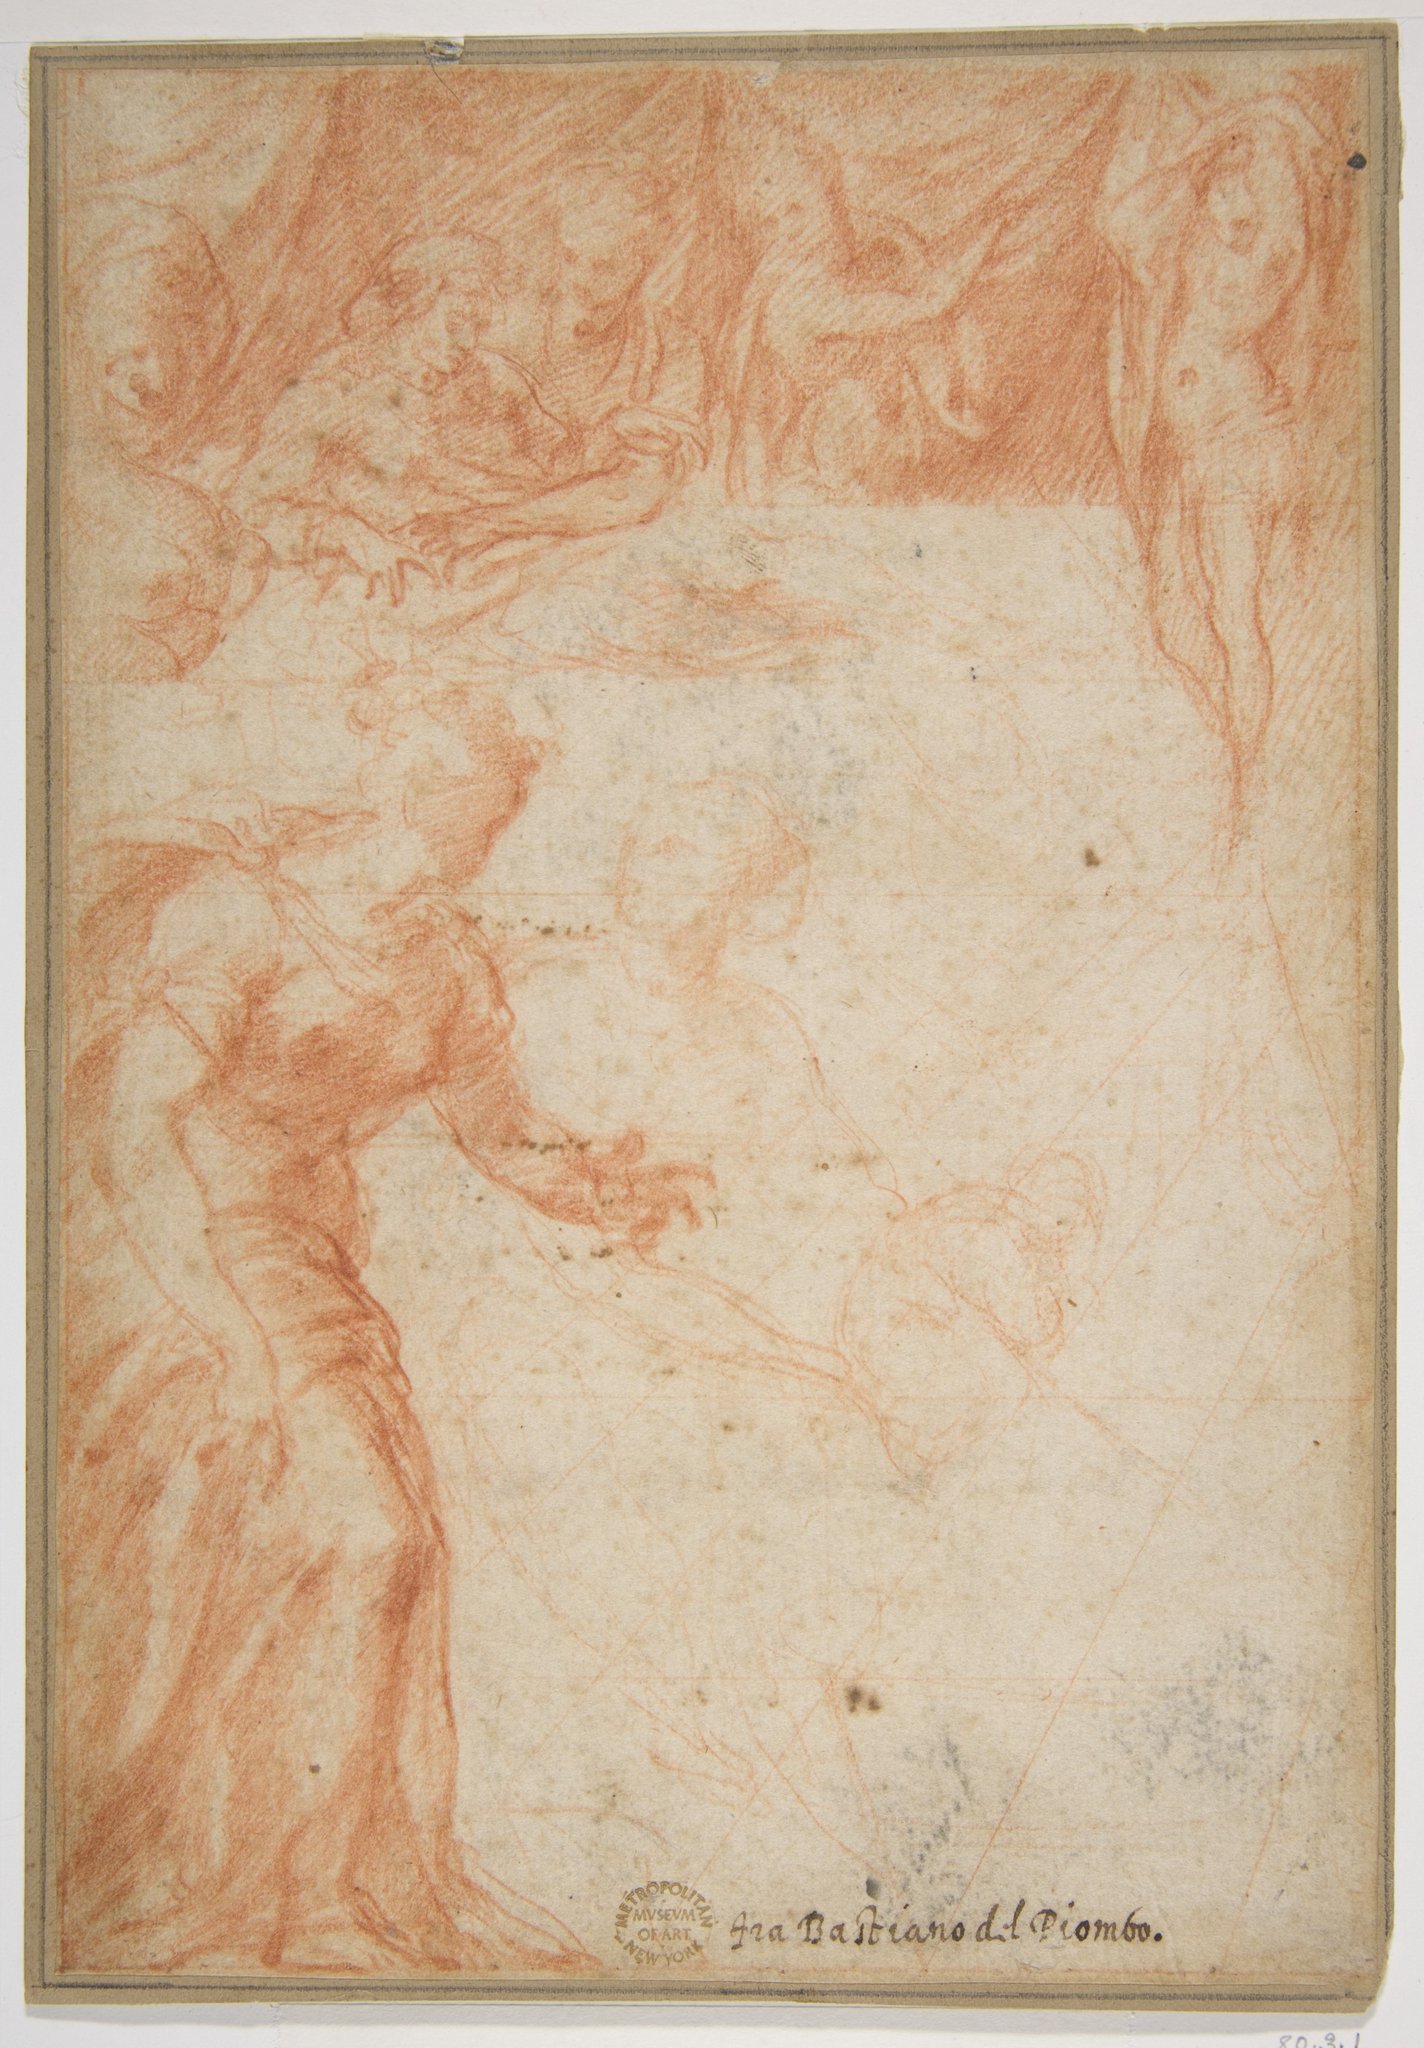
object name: drawing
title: Figural Studies for a Scene (The Birth of the Virgin or Saint John the Baptist?)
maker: rosso fiorentino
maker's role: artist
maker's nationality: italian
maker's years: 1494-1540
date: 1520-1530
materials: chalk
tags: saint john the baptist,virgin mary,birth